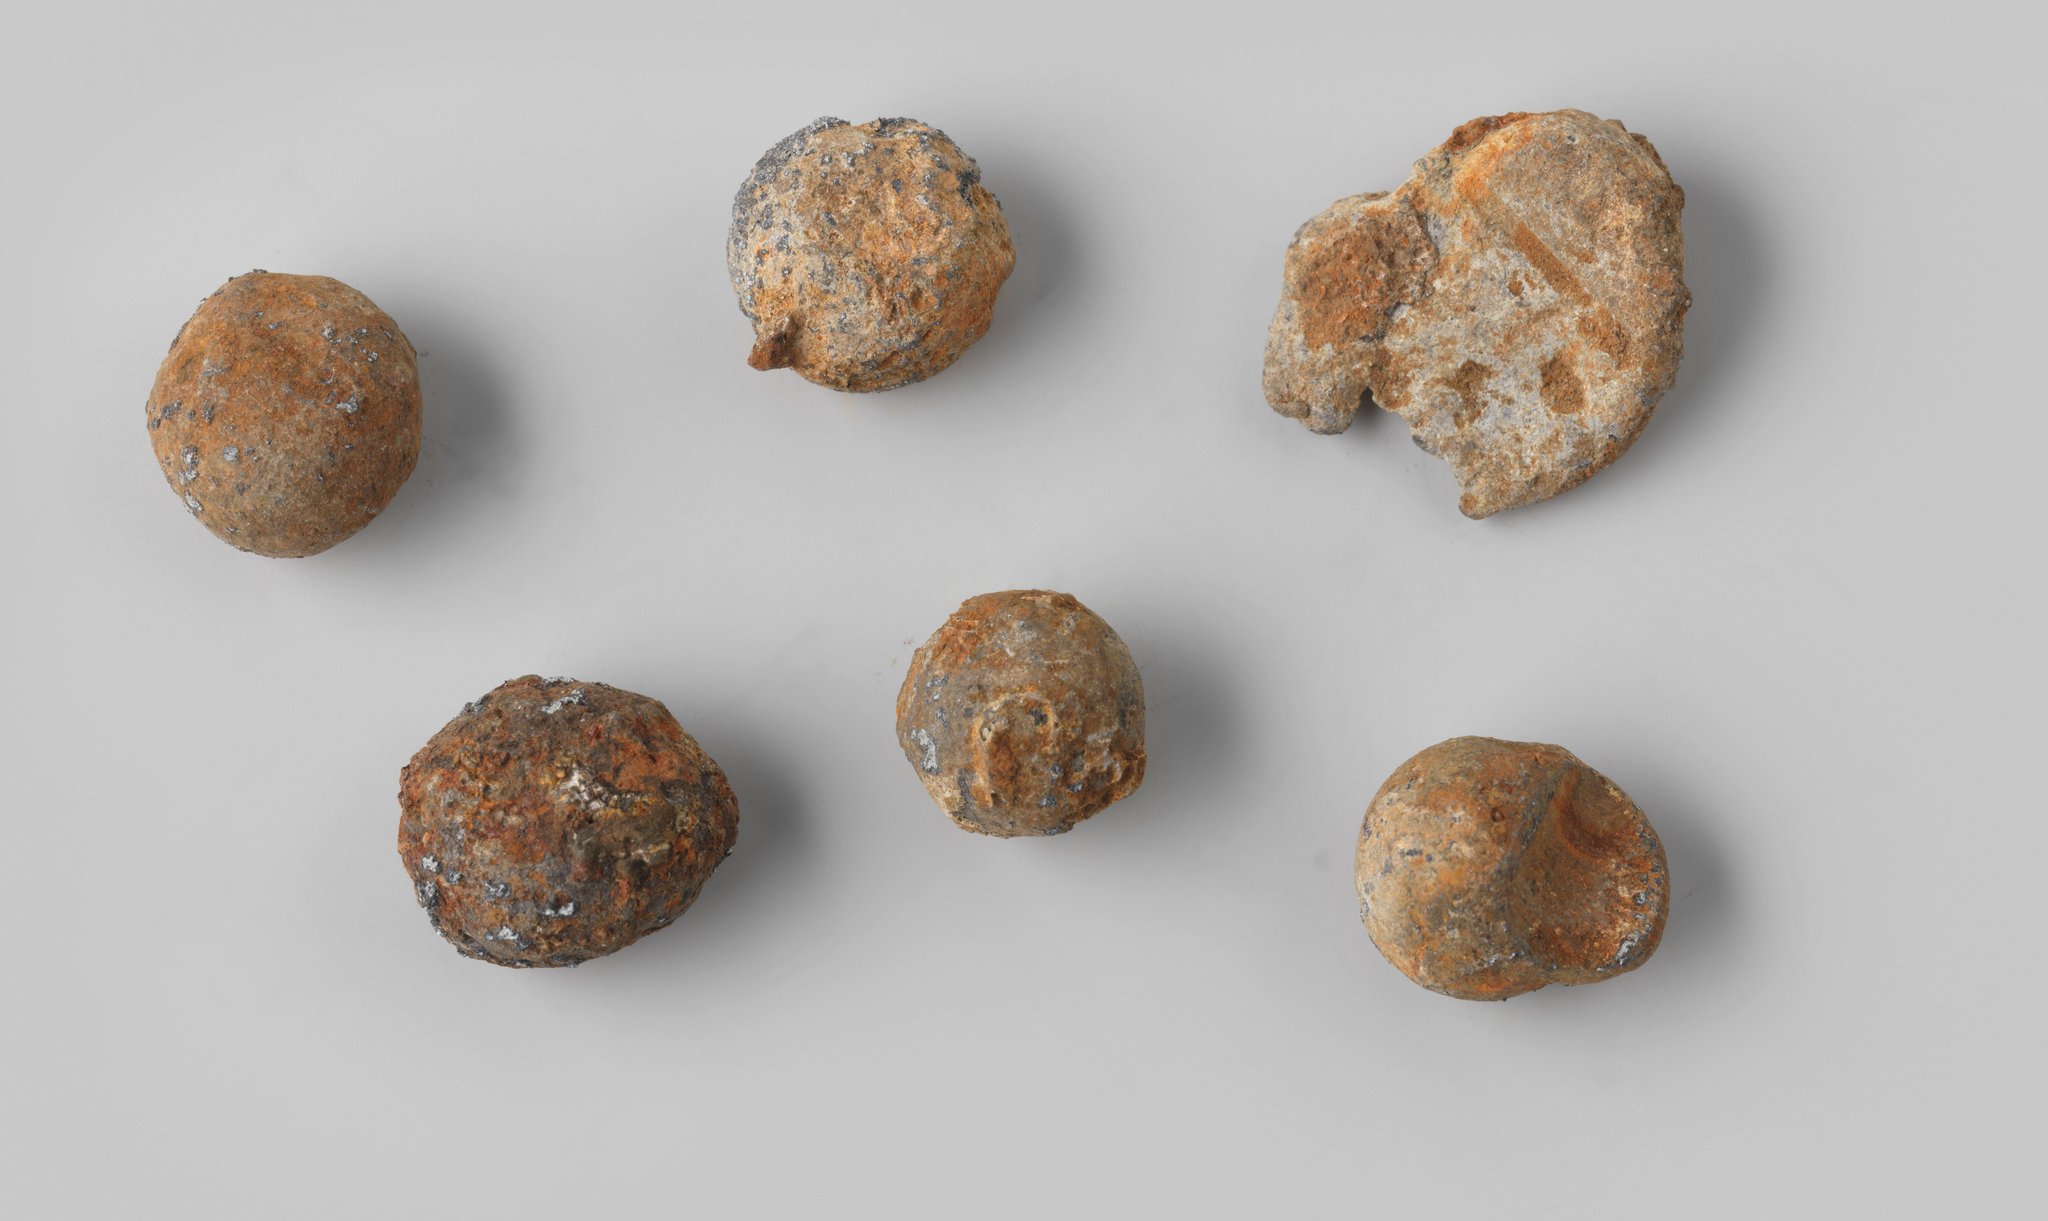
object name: bullet ammunition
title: Kogels uit het wrak van de Oost-Indiëvaarder Hollandia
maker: Anonymous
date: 1700-1743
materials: lead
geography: netherlands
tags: verenigde oostindische compagnie, hollandia (schip), annet